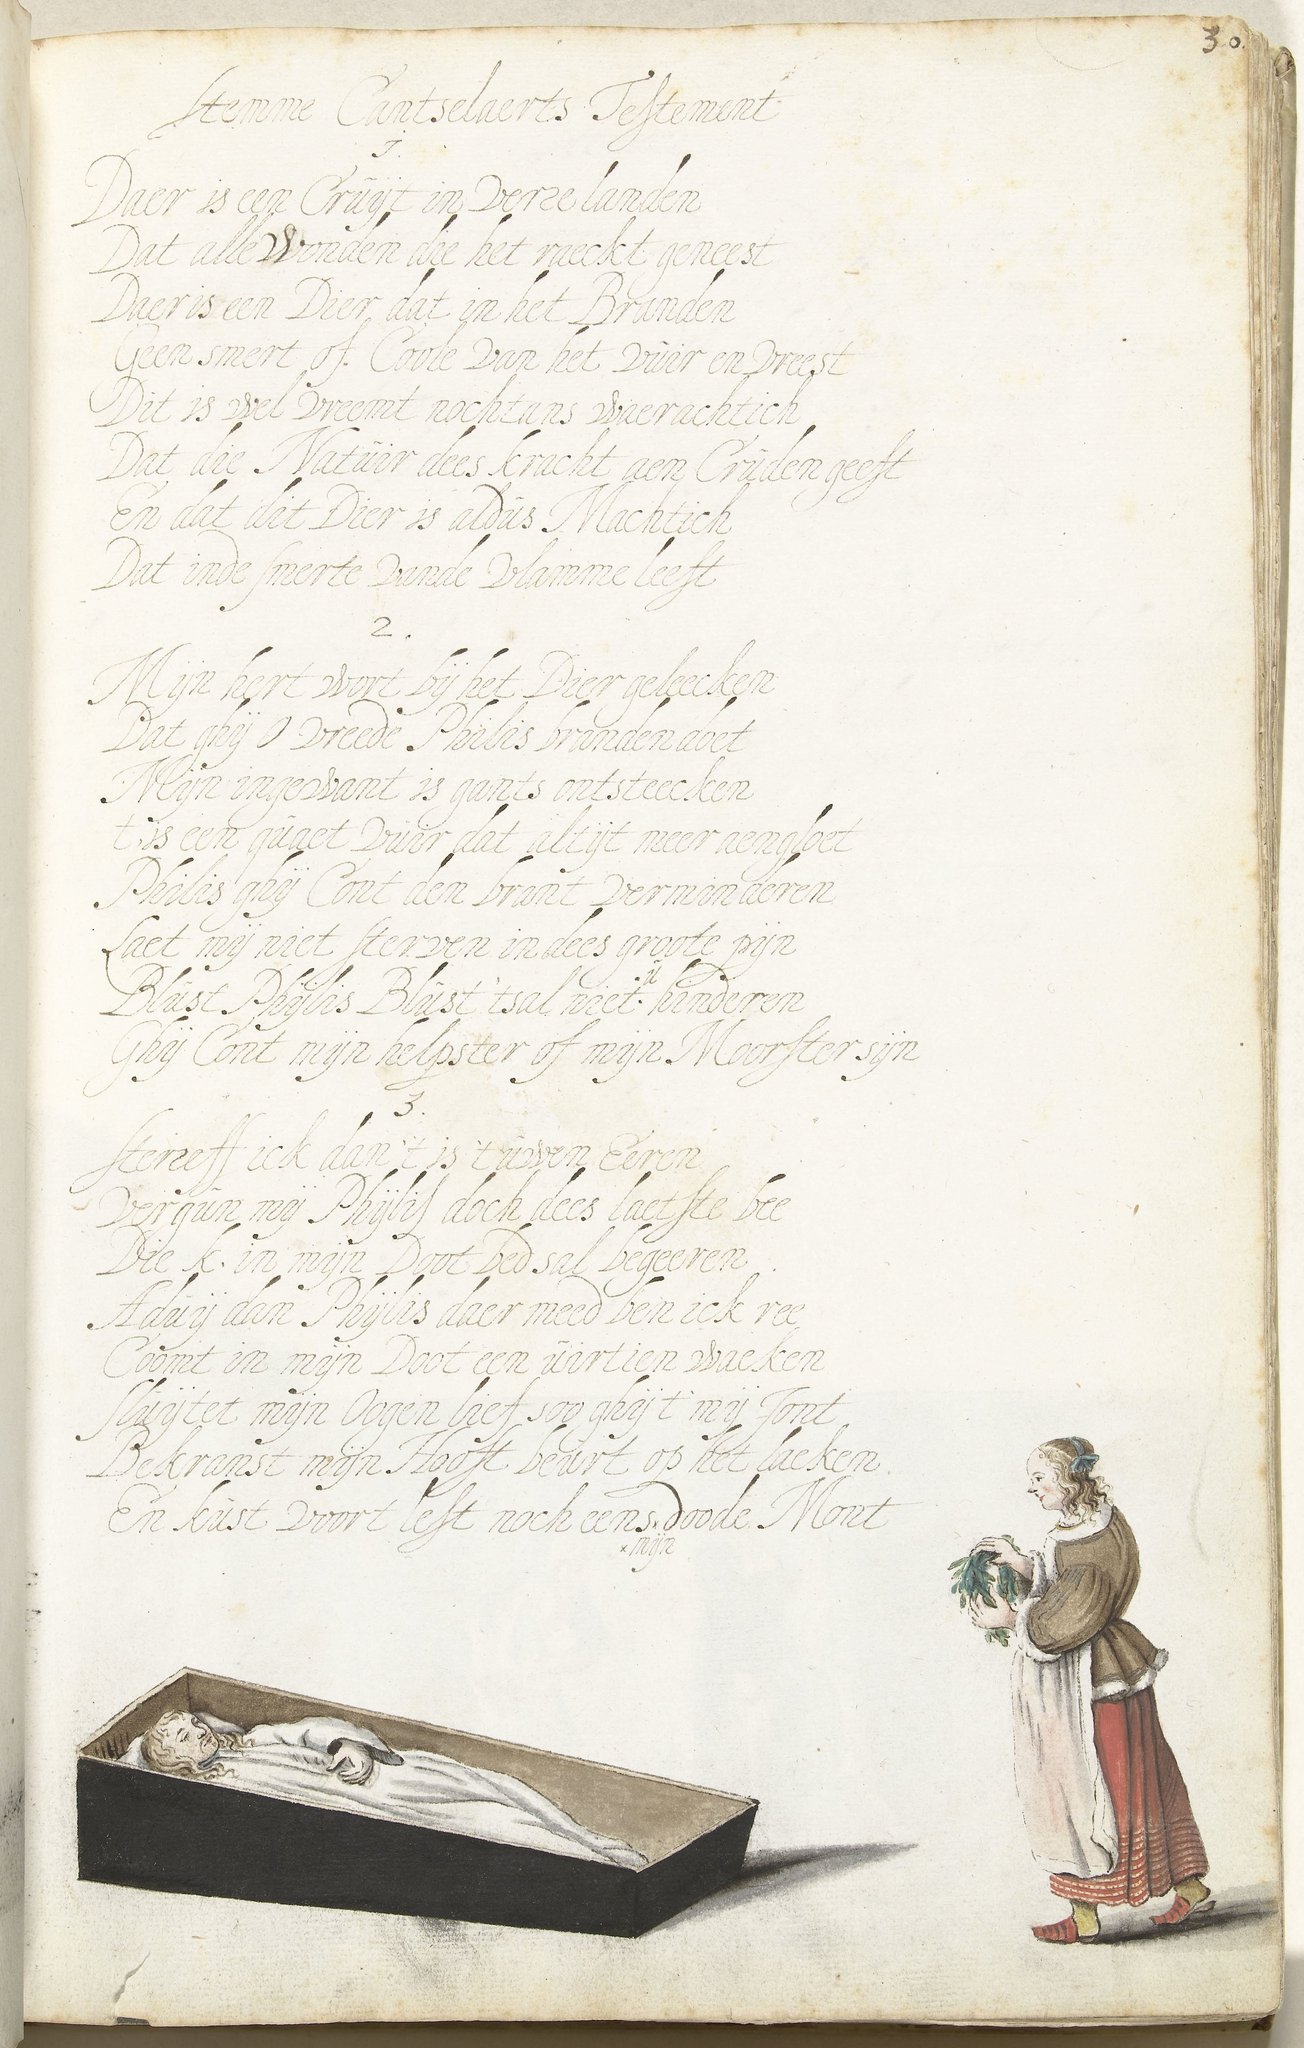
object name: drawing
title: Vrouw met het stoffelijk overschot van haar geliefde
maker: gesina ter borch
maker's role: draughtsman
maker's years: 1633-1690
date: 1653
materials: ink, paper, watercolor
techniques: brush, calligraphy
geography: zwolle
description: Vrouw met het stoffelijk overschot van haar geliefde naast een liefdesklacht op de melodie van Cantselaerts Testement.